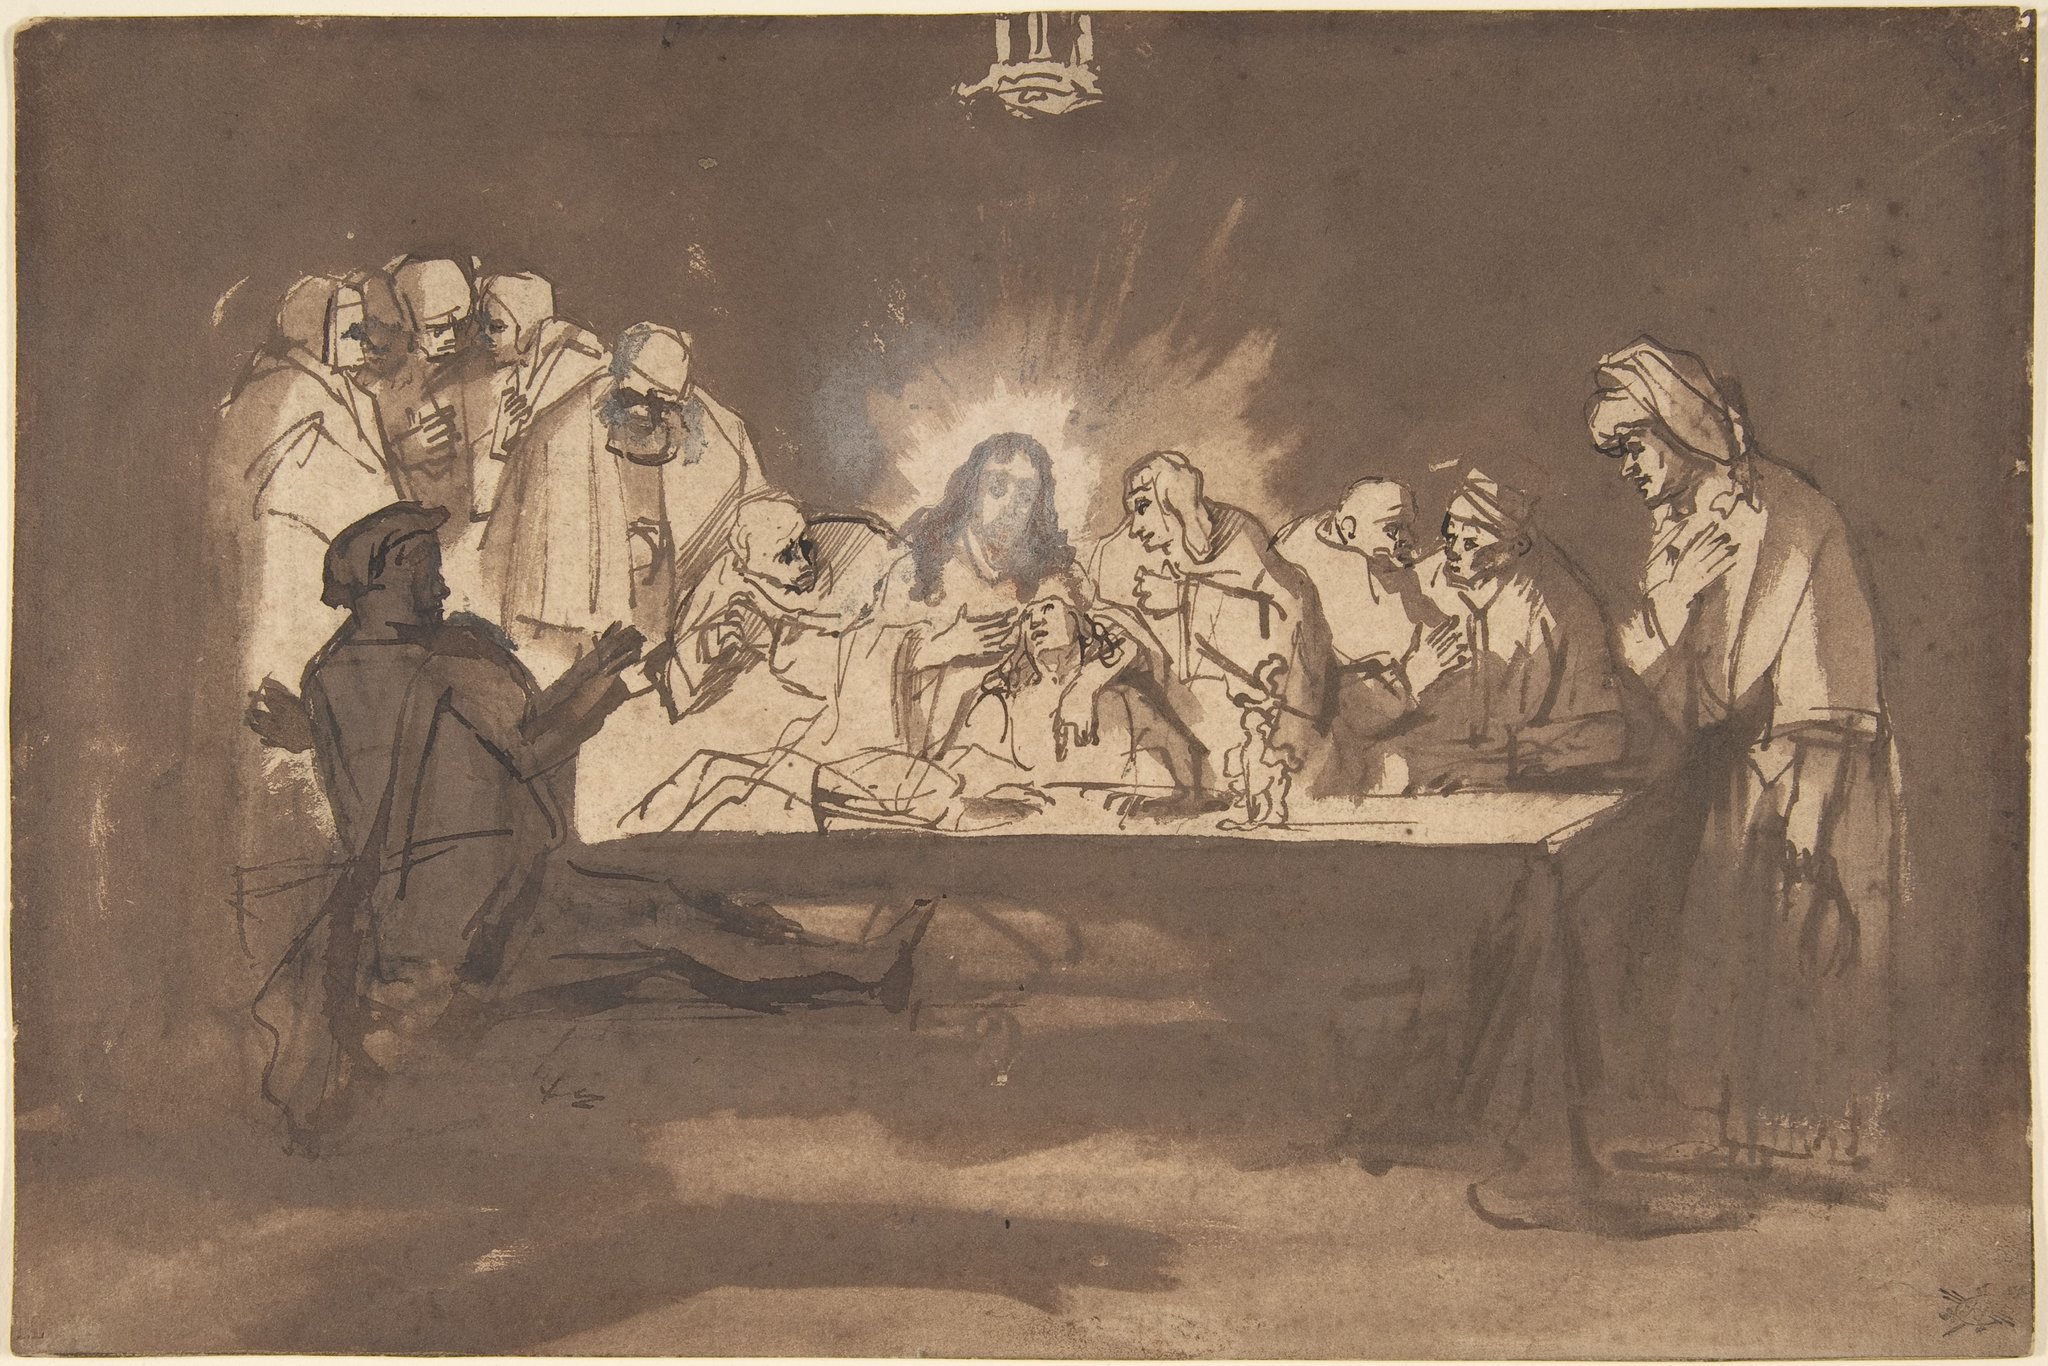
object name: drawing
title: The Last Supper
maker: philips koninck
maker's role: artist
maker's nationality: dutch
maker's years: 1619-1688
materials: chalk, gouache, ink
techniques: brush, heightening, pen, wash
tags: last supper